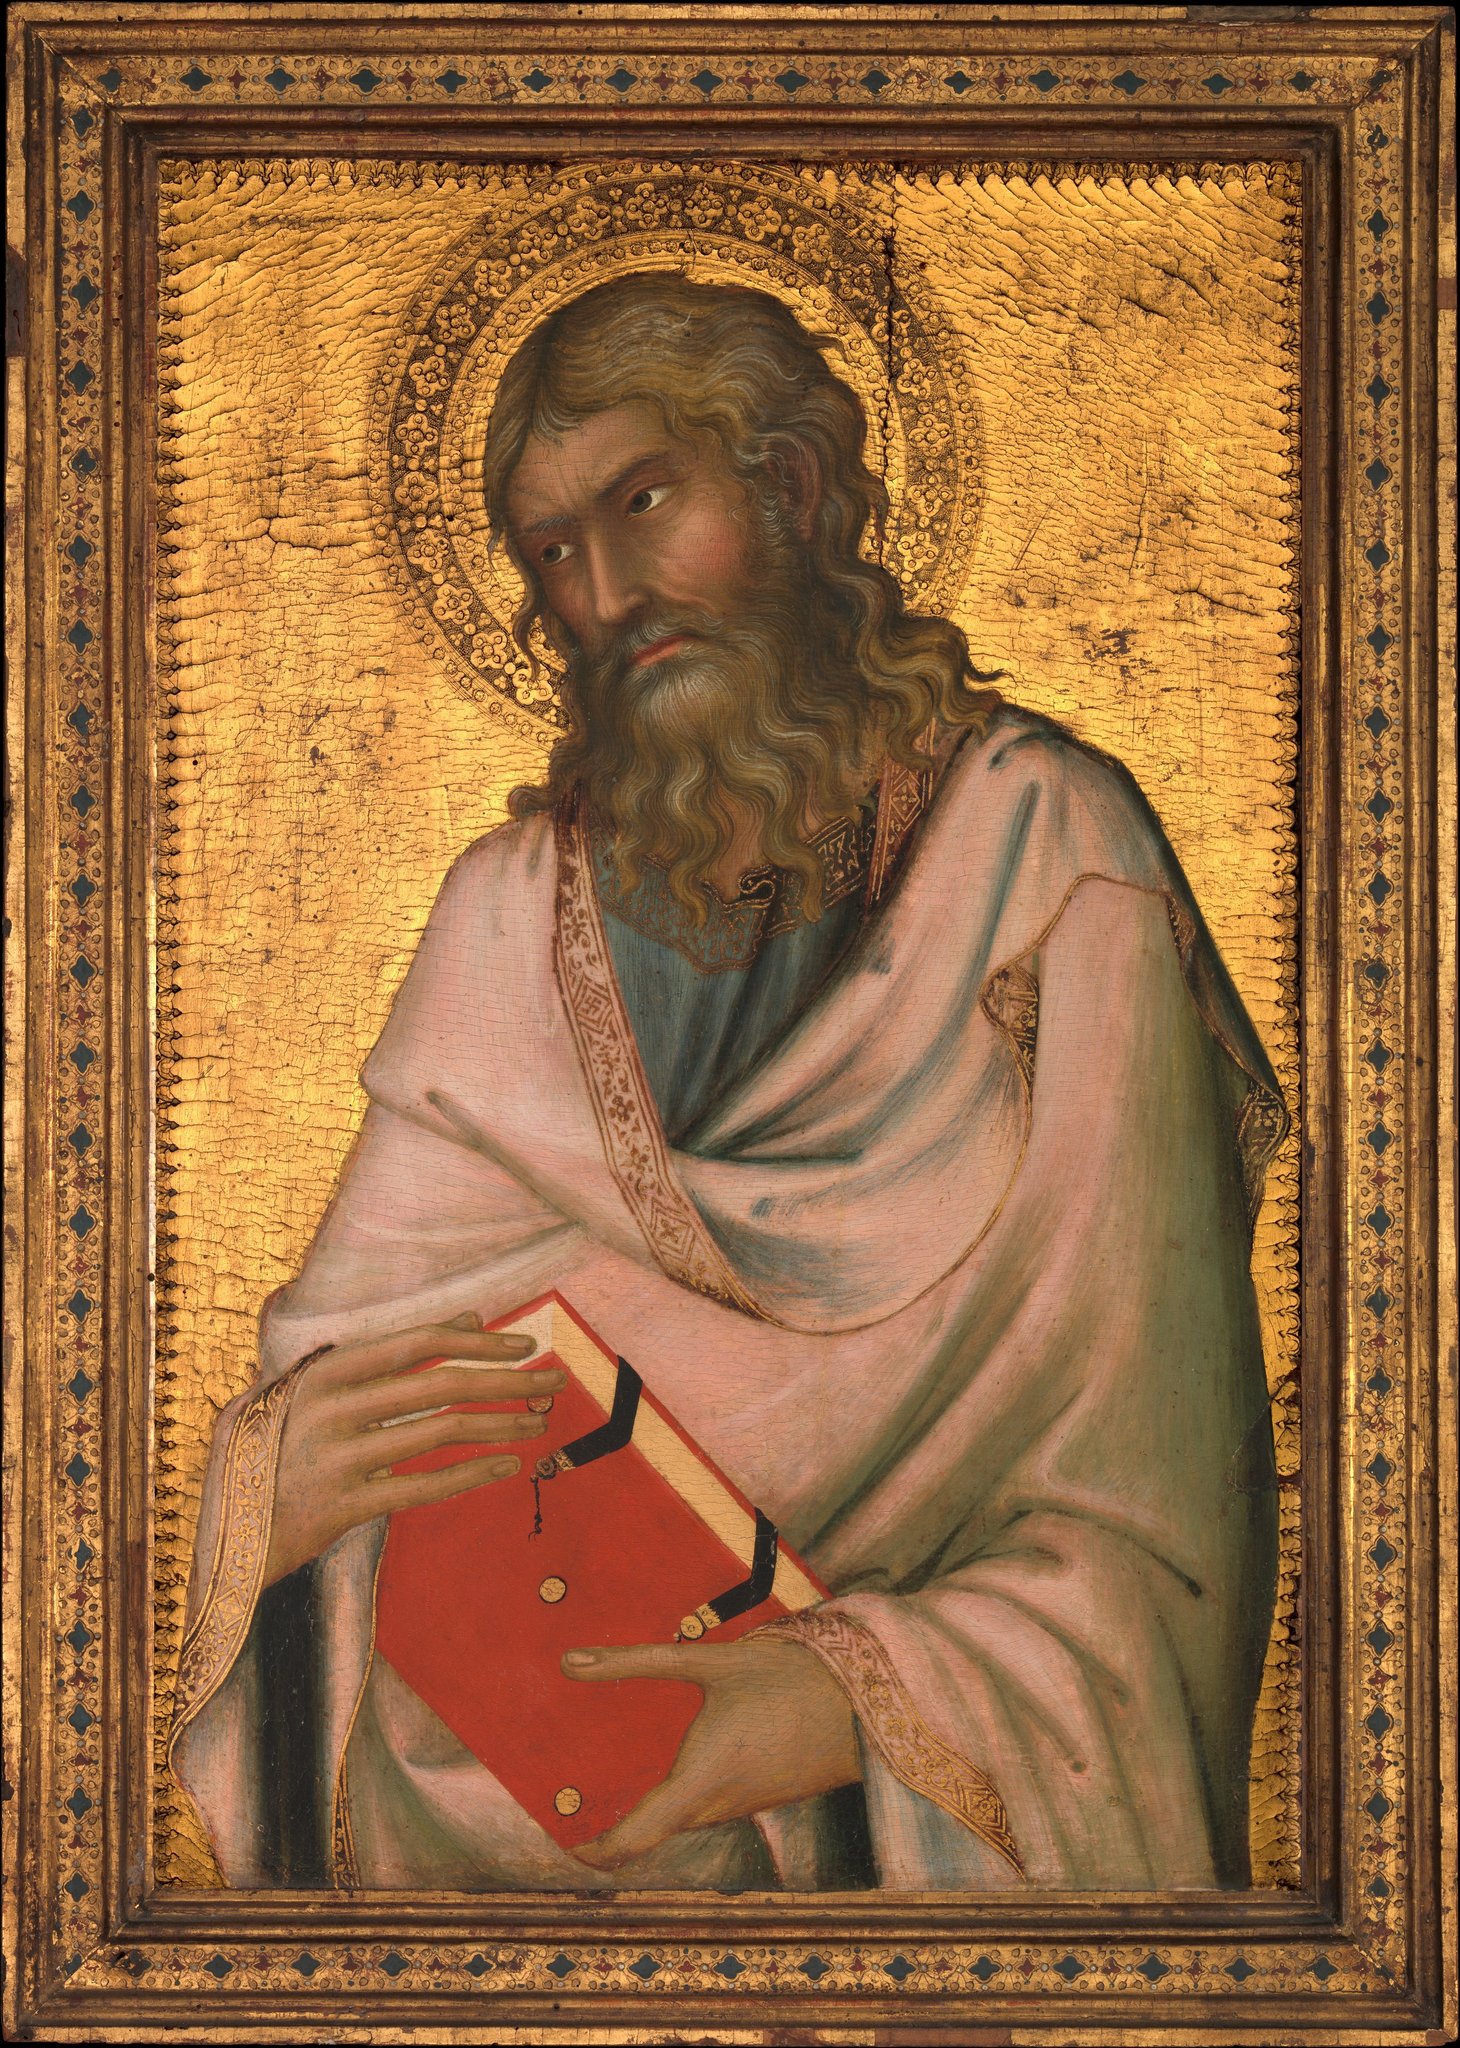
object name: painting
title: Saint Andrew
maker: simone martini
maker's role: artist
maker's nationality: italian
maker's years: 1315-1344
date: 1326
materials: gold leaf, paint, wood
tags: men,saints